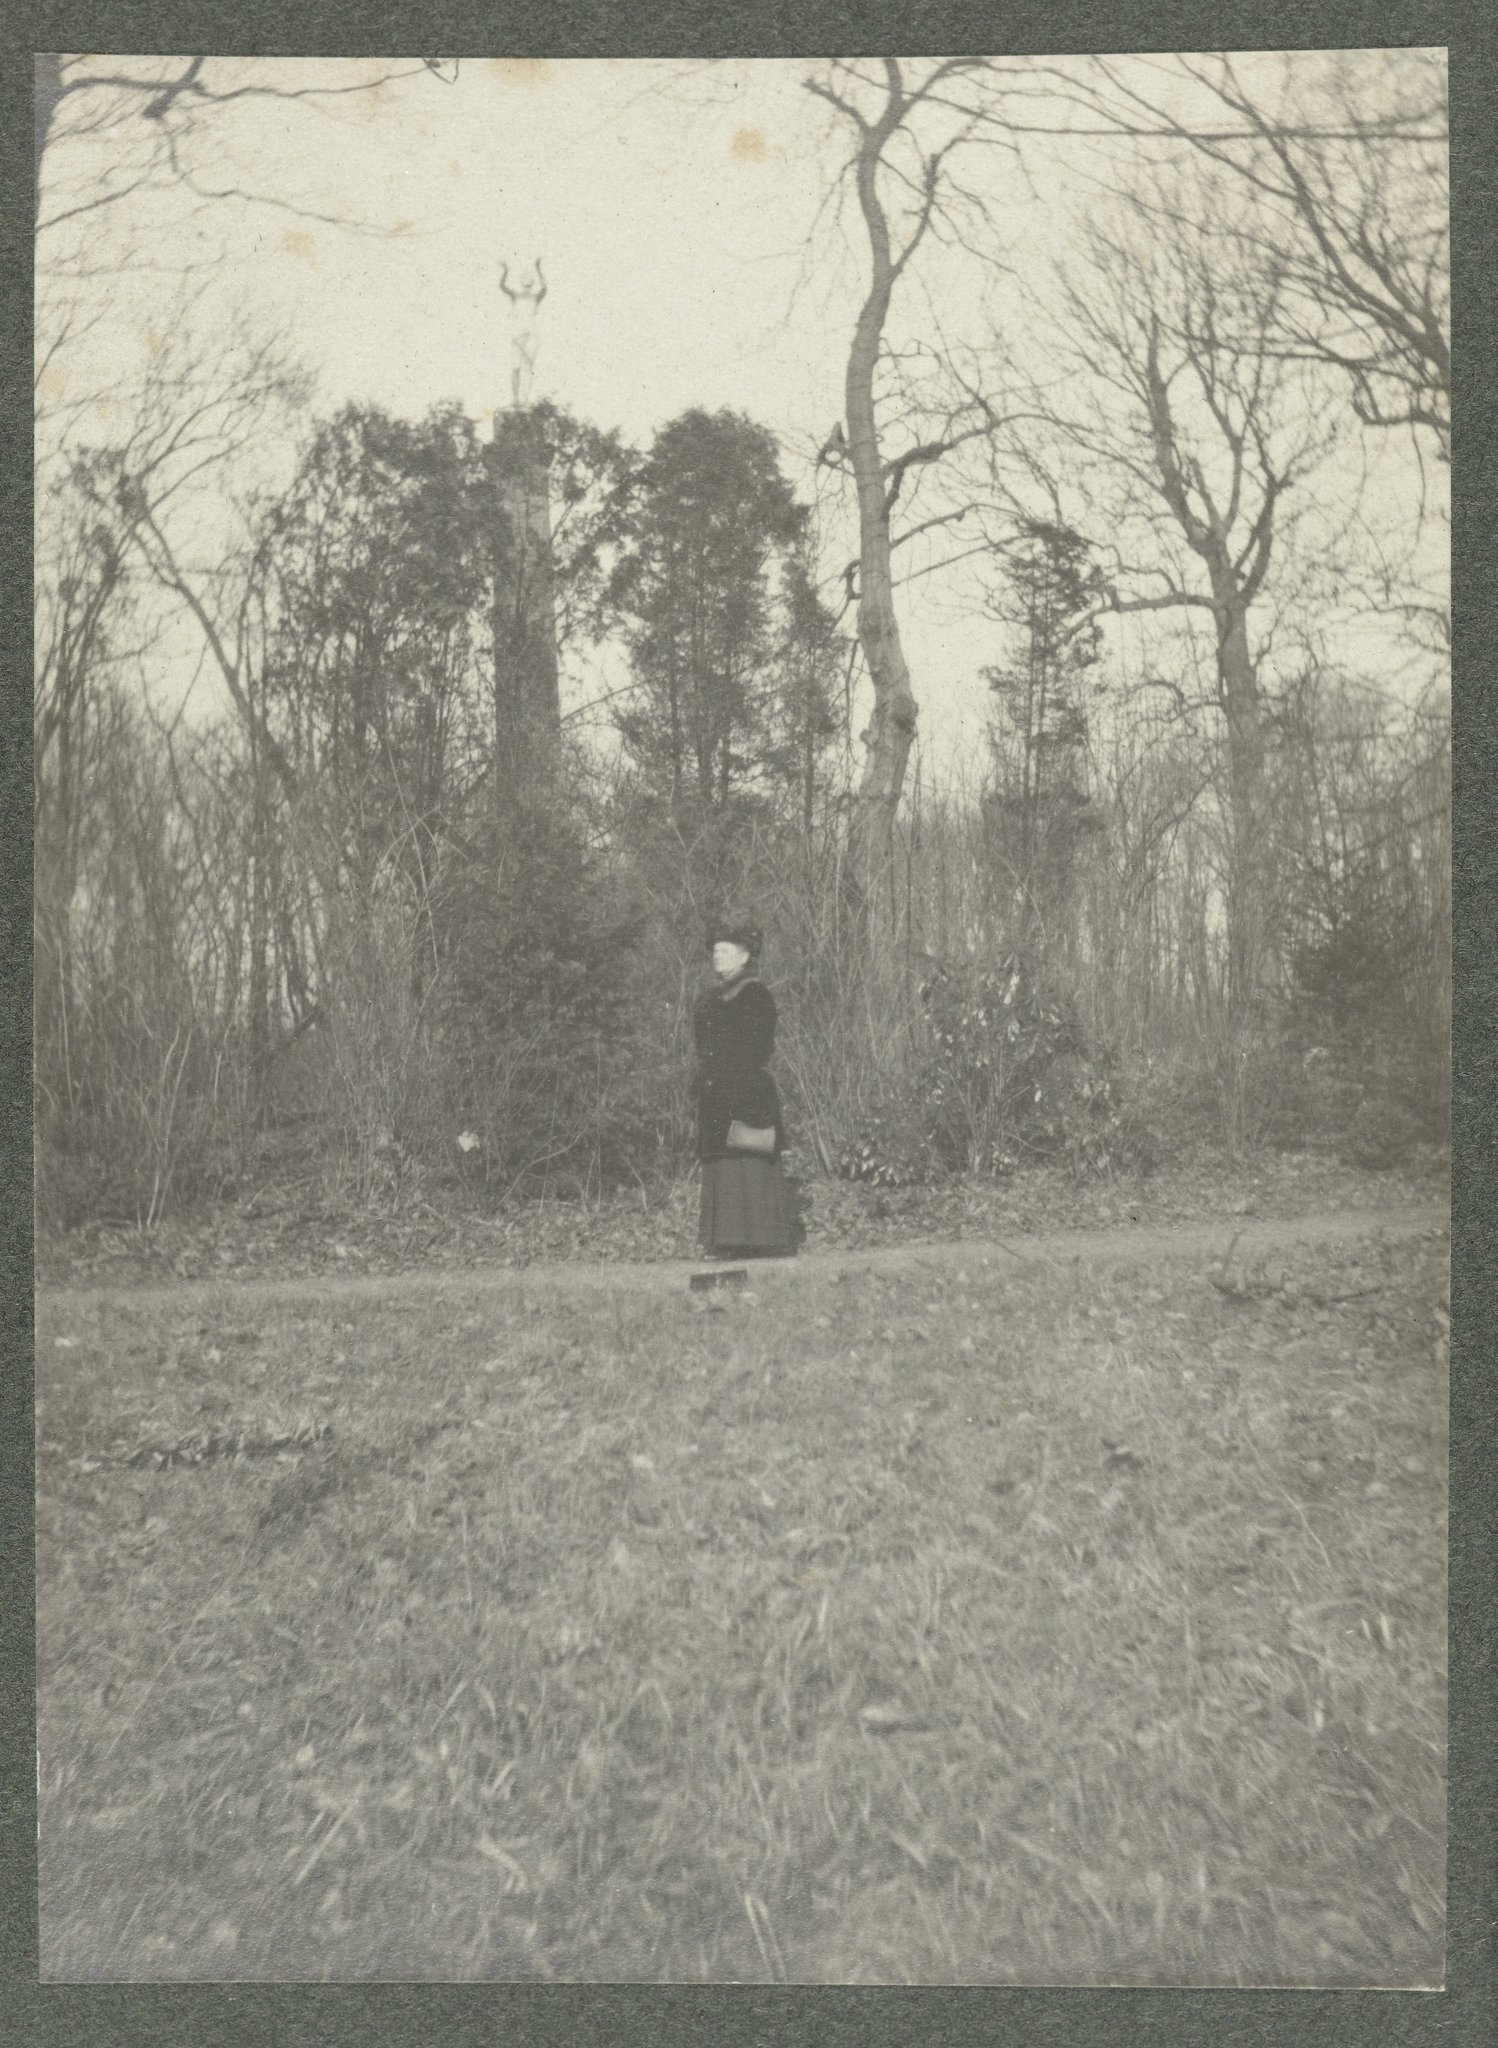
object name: photograph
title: Margo J.J. Kessler-de Lange wandelend op landgoed De Paauw in Wassenaar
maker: geldolph adriaan kessler (dolph)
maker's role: fotograaf, industrieel, voetballer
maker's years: 1884-1945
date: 1913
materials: paper, photographic support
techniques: gelatin silver print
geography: wassenaar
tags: huize de paauw